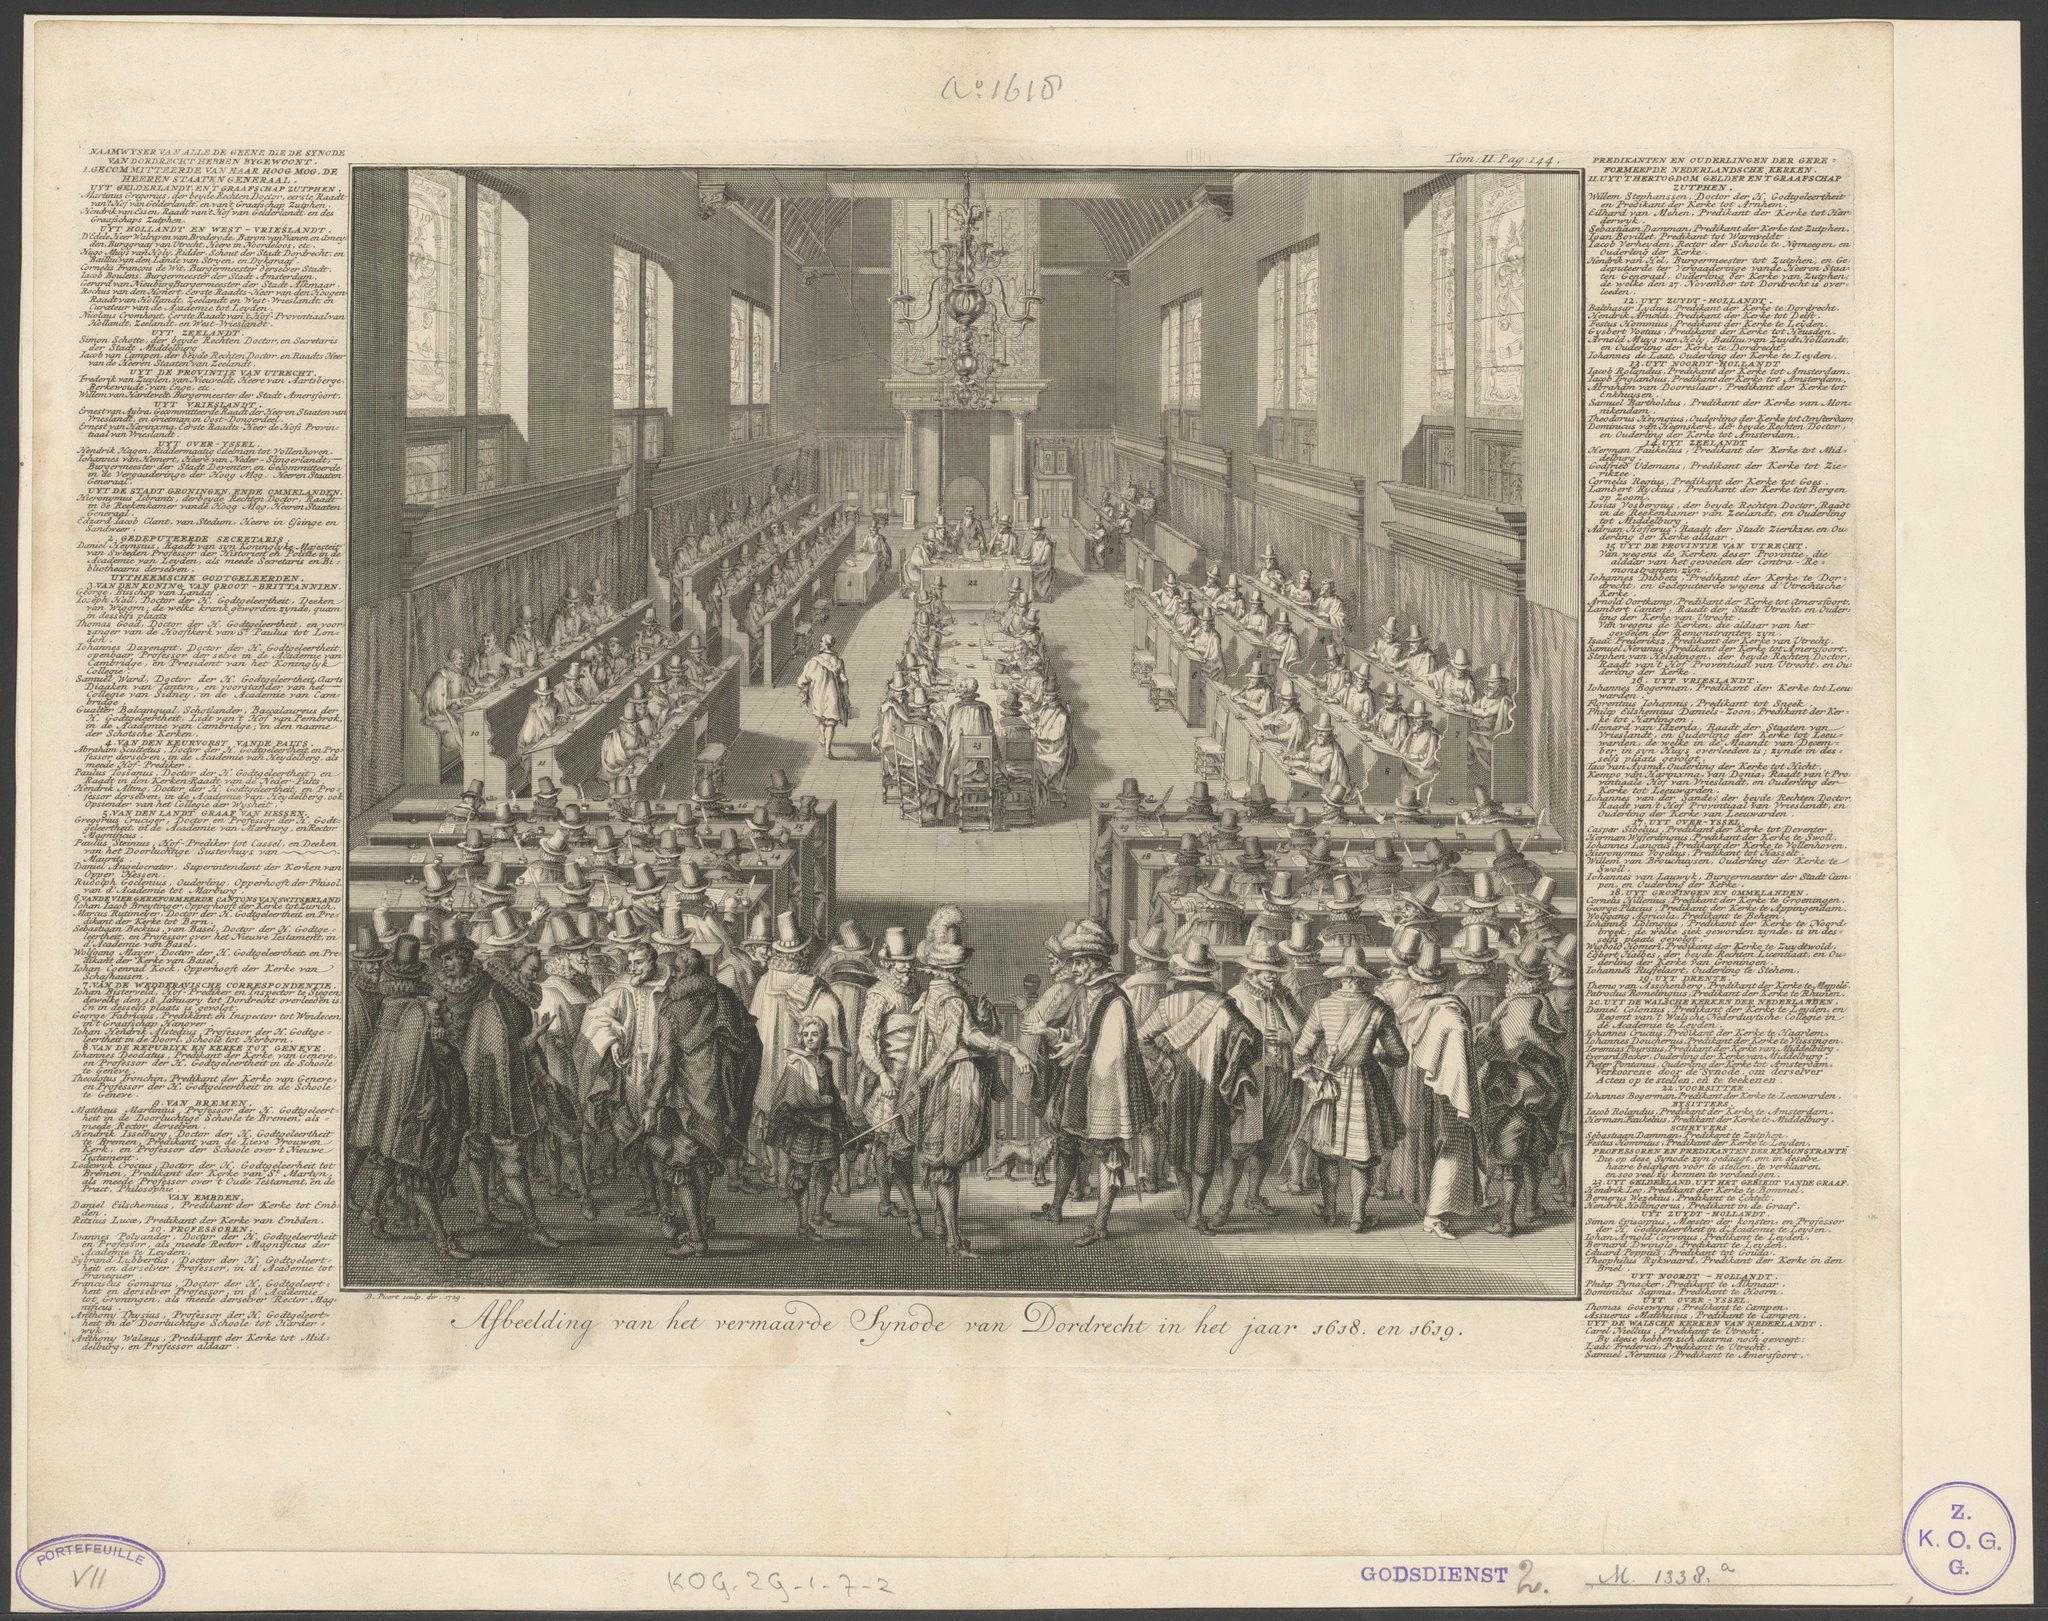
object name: print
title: Afbeelding van het vermaarde Synode van Dordrecht in het jaar 1618. en 1619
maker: bernard picart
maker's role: draughtsman, print maker, publisher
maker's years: 1673-1733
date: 1729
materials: paper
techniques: engraving, etching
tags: organizations, assemblies, etc. in protestant churches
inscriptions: collector's mark: Lugt 1641, stamp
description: De opening van nationale synode te Dordrecht op 13 november 1618. De grote zaal van de Kloveniersdoelen met alle aanwezigen en toeschouwers. De deelnemers aan de synode zijn met cijfers aangeduid met de corresponderende legenda in de kolommen aan weerszijden van de voorstelling. Rechtsboven genummerd: Tom: II. Pag: 144. Onderwerpsrubrieken binnen de Atlas Zeden en Gewoonten: Godsdienst, Ned. Hervormden, (Oudtijds Gereformeerden), Synode van Dordrecht.